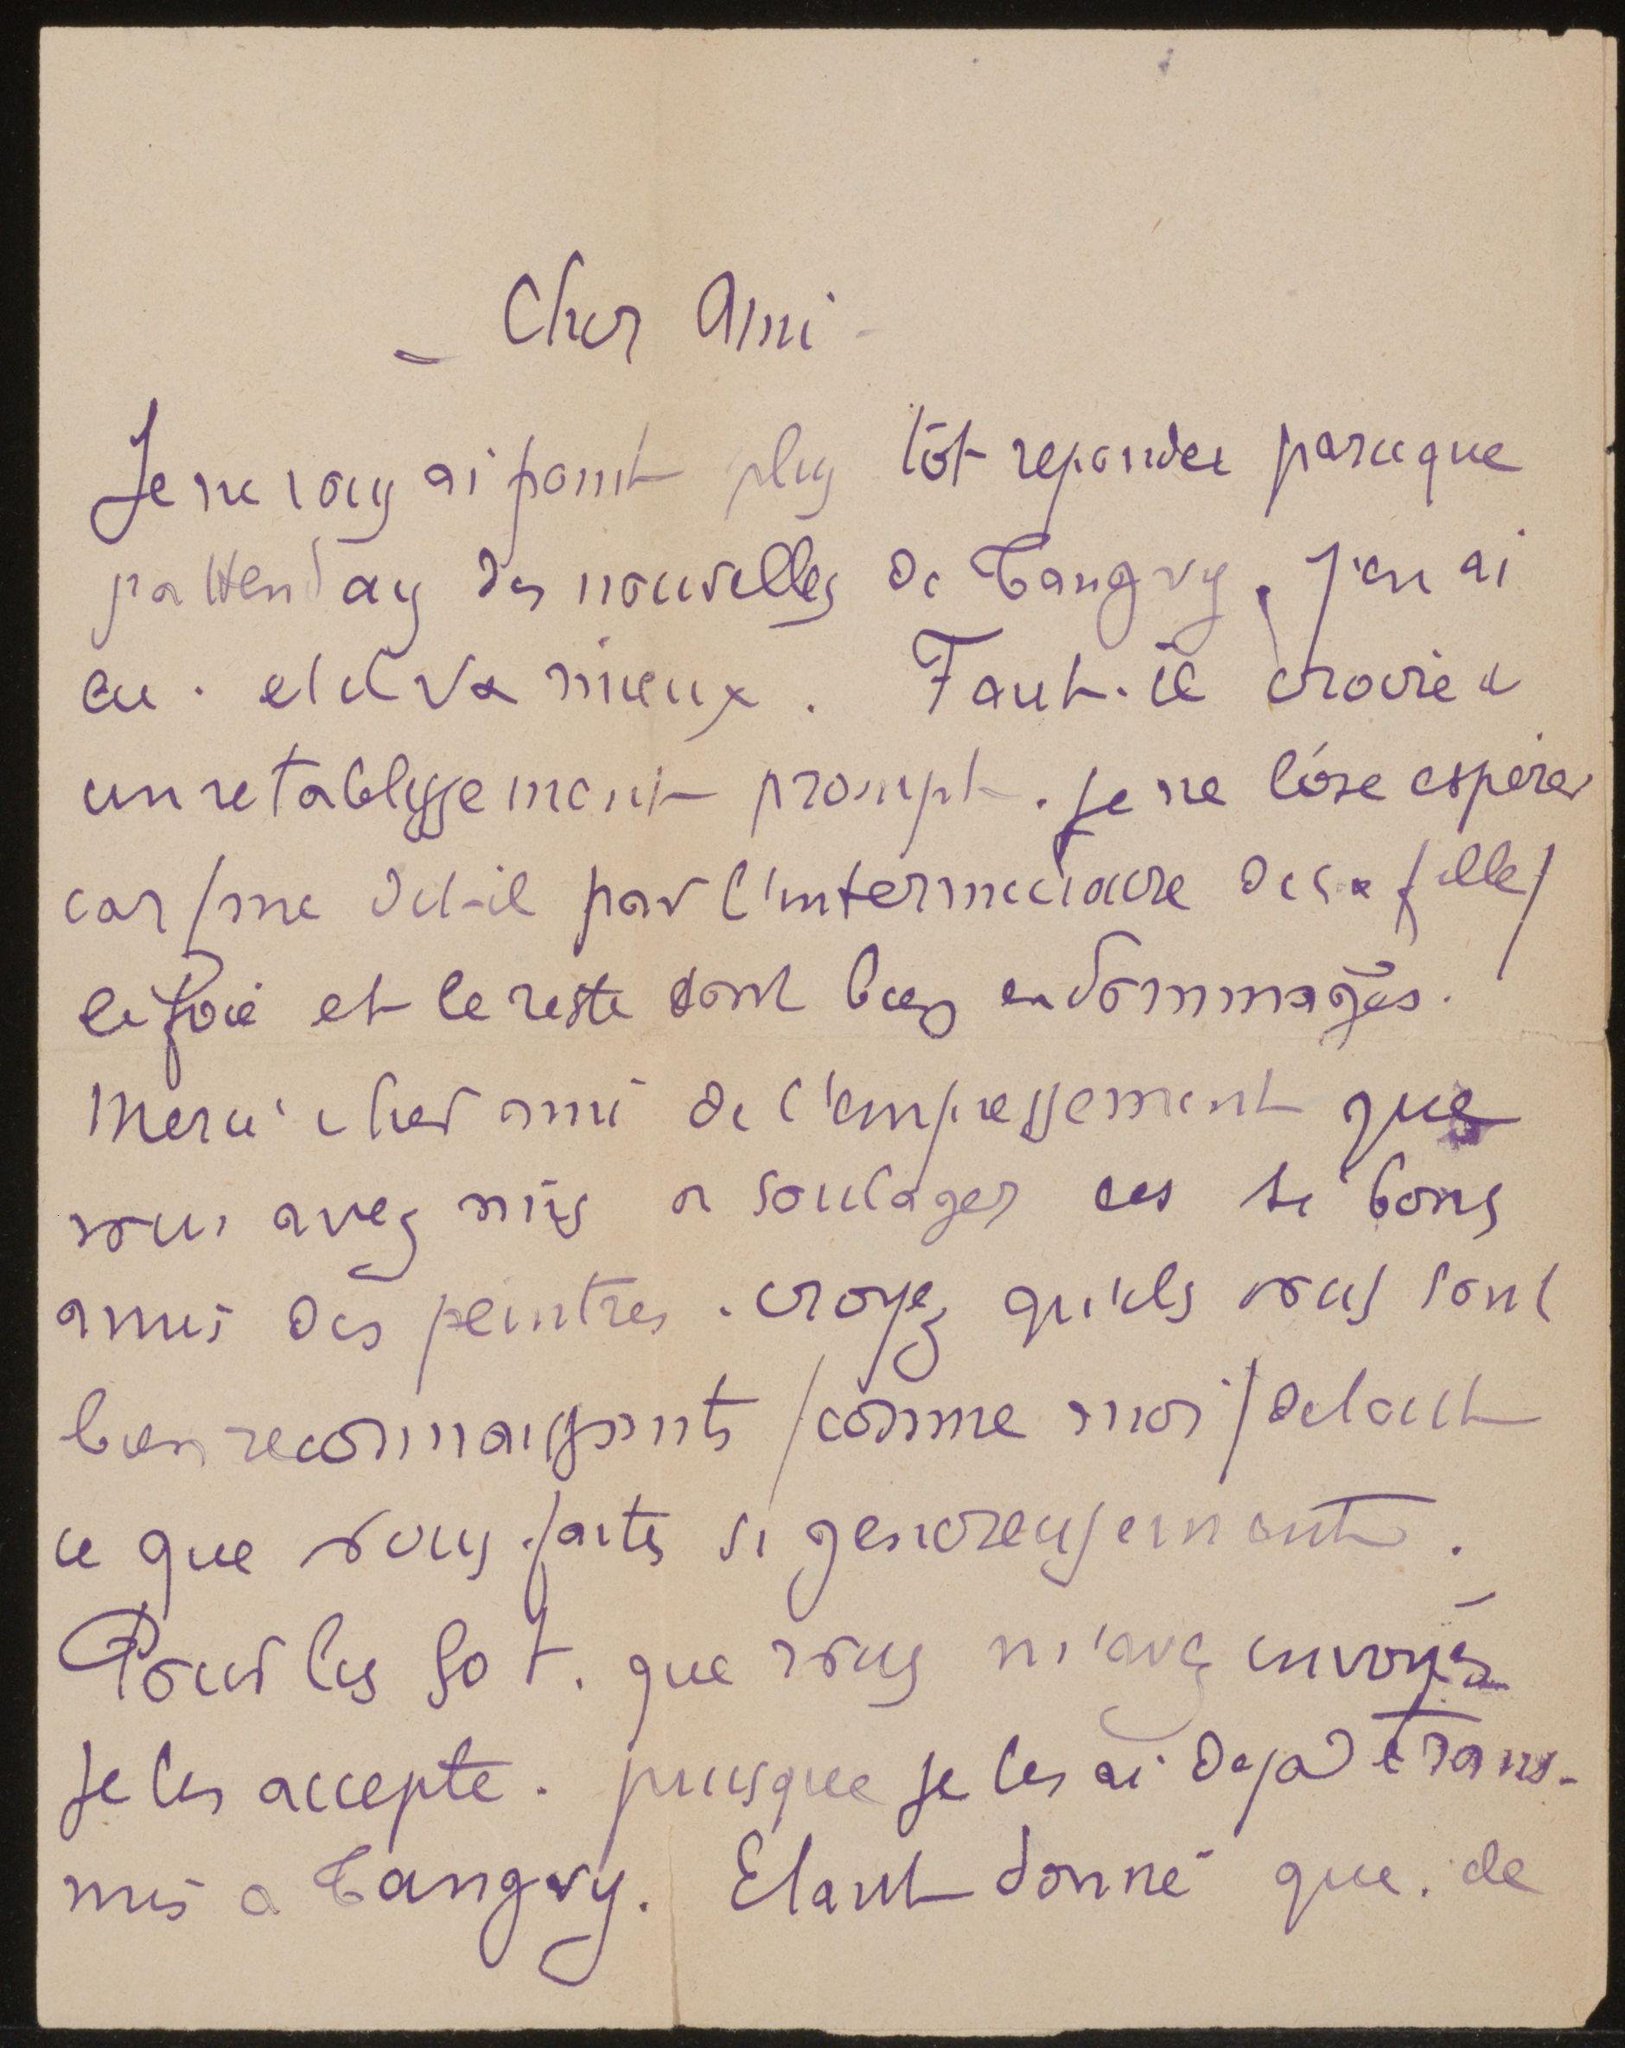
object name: letter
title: Brief aan Andries Bonger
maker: émile bernard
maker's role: print maker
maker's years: 1868-1941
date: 1892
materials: ink, paper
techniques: pen, writing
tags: charles baudelaire, publisher, louis renard, andries bonger, honoré de balzac, leonardo da vinci, paris, emile zola, passions, emotions, affections, literature ~ arts, painting (including book-illumination, miniature-painting), amsterdam